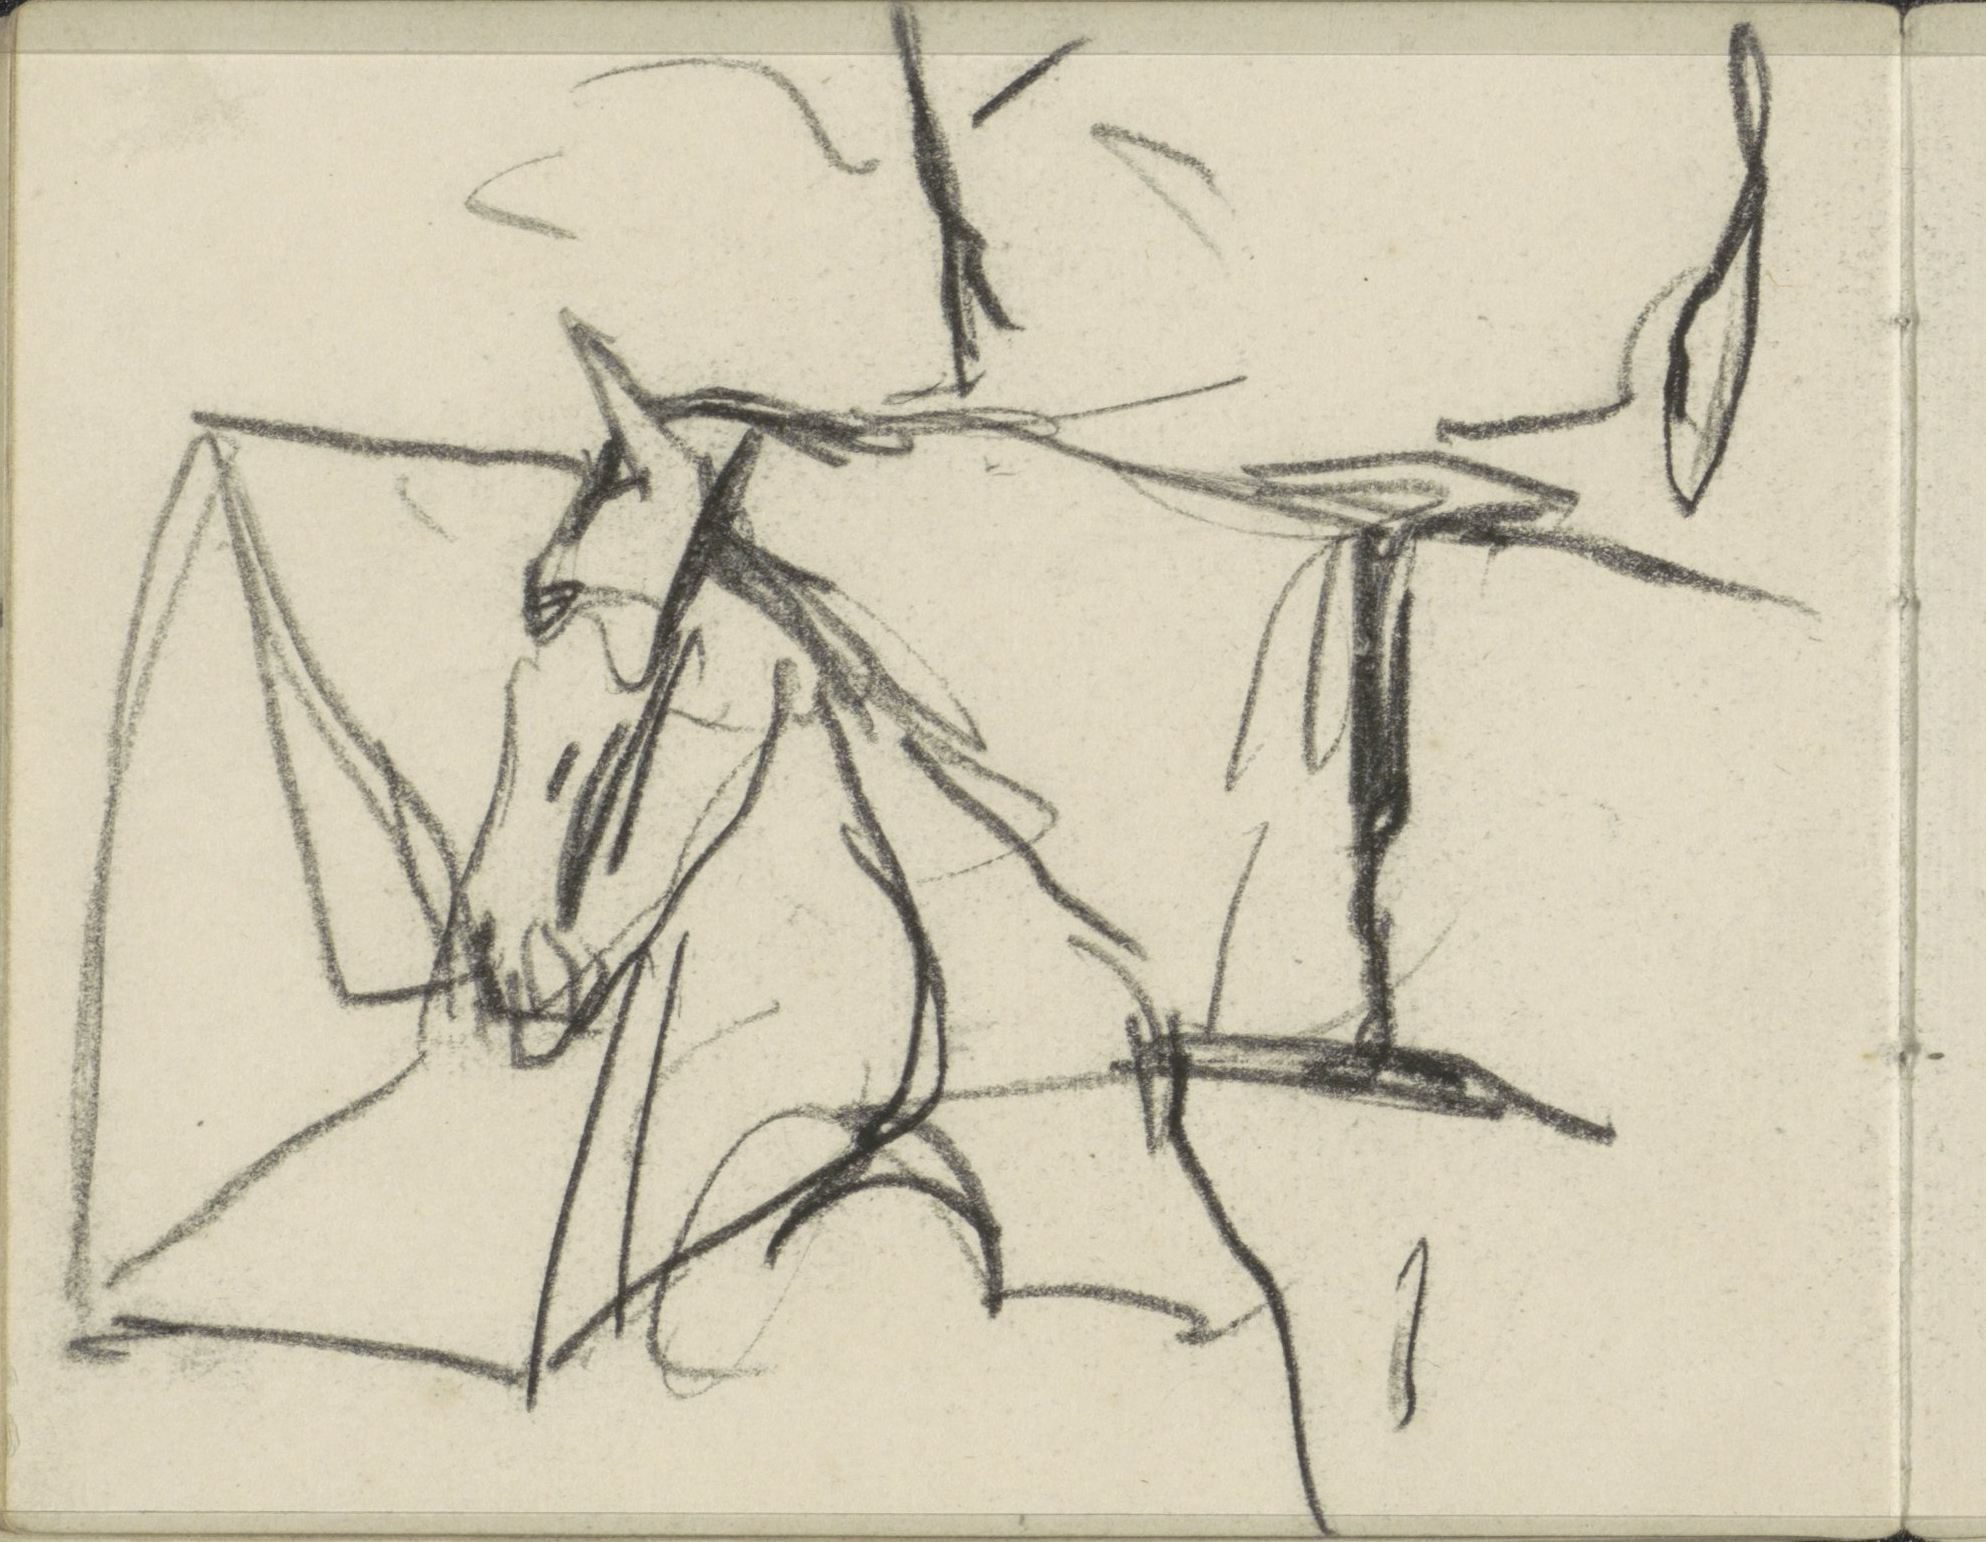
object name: sketchbook leaf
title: Paard met tuig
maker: george hendrik breitner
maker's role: draughtsman, painter, print maker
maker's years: 1857-1923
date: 1886-1895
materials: chalk, paper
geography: amsterdam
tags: horse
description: Pagina 43 uit een schetsboek met 34 bladen.